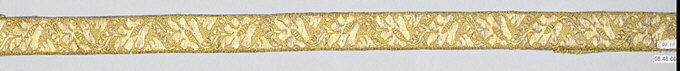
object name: galloon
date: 1600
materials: metal thread, silk